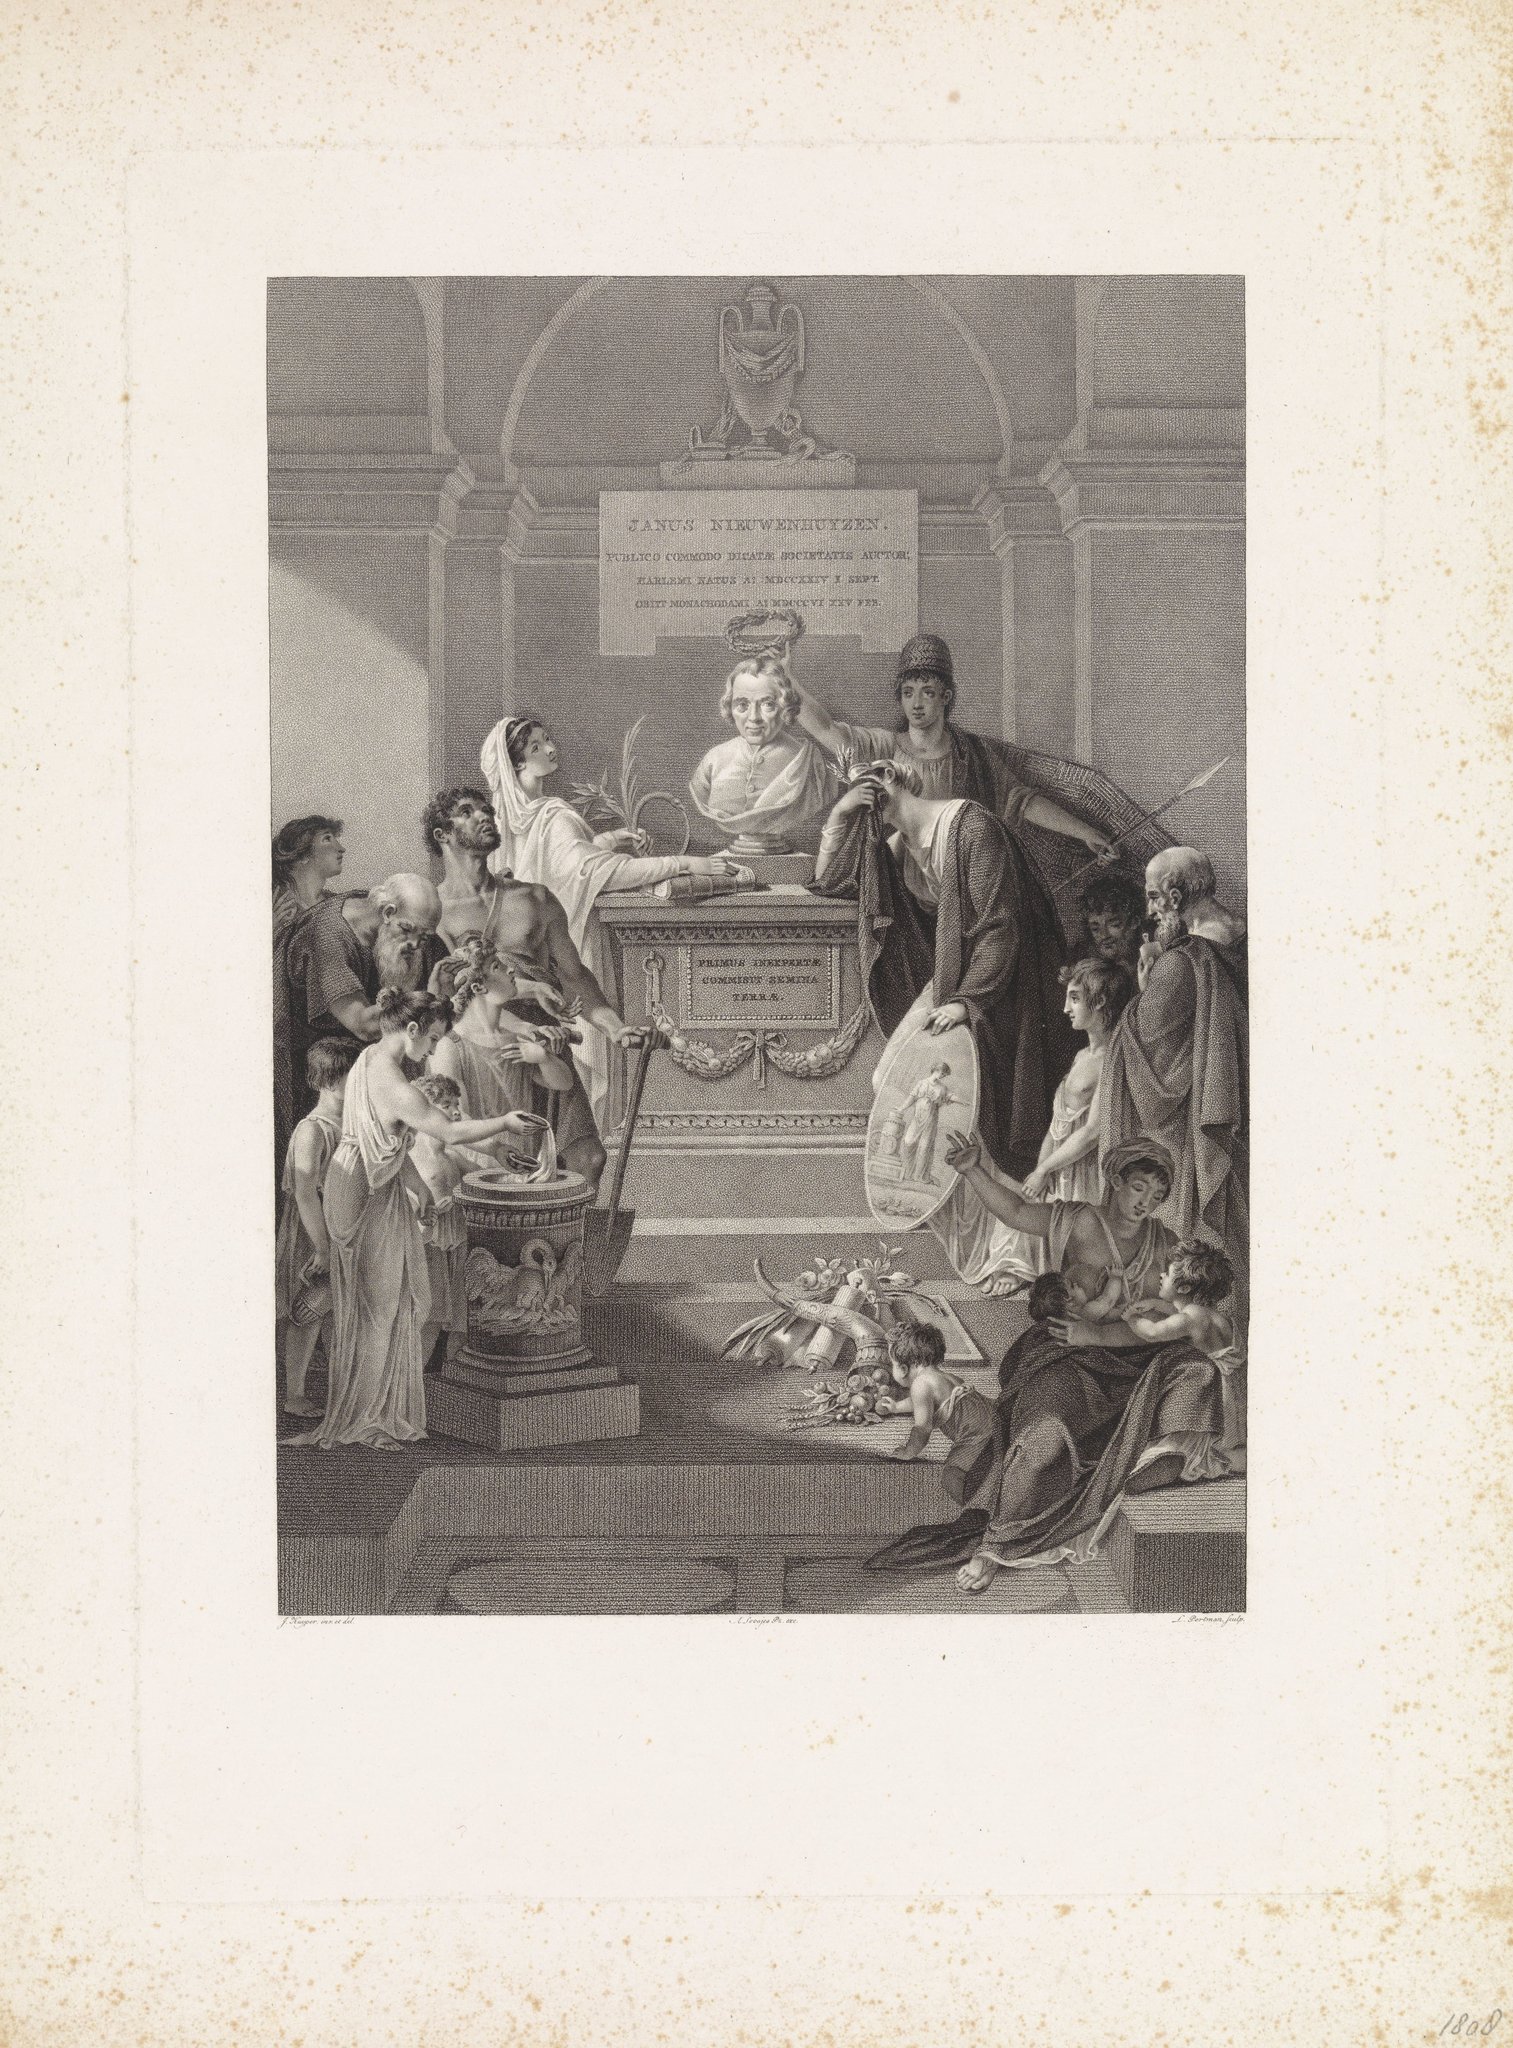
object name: print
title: Allegorische voorstelling met gedenksteen voor Jan Nieuwenhuyzen, overleden in 1806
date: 1806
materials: paper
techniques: etching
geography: haarlem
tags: haarlem, amsterdam, jan nieuwenhuyzen, 'cornucopia', horn of plenty, charity, 'caritas'; 'carità' (ripa) ~ one of the three theological virtues, offering; 'offerta overo oblatione' (ripa) (+ allegorical scene, i.e. two or more personifications involved in an action), symbols, allegories of peace, 'pax'; 'pace' (ripa), serpent ouroboros, urn, crowning with laurel, love towards god; 'amore verso iddio' (ripa), grave, tomb and other grave-forms and grave-markers, youth, adolescence, 'iuventus'; 'adolescenza', 'gioventù' (ripa), the bible as a book, symbols of particular nations, states, districts, etc.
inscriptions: collector's mark: Lugt 2228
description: Gedenksteen voor Jan Nieuwenhuyzen, overleden 25 februari 1806. Op een altaar in een nis staat de buste van Jan Nieuwenhuyzen, stichter van de Maatschappij Tot Nut van 't Algemeen. Daarboven een kader met de naam, geboorte- en sterfdatum van Nieuwenhuyzen. Op het altaar een motto in het Latijn (Hij plantte daar niets stond). De buste wordt gelauwerd door de Hollandse Maagd. Voor haar de personificatie van de Maatschappij die haar betraande gezicht bedekt en leunt op het altaar en haar schild. Aan de andere kant van het altaar kijkt de Godsvrucht op naar de buste. Haar hand rust op een bijbel (Zaligheid), in de andere houdt zij de slang die in zijn eigen staart bijt (Eeuwigheid) en een palmtak (Vrede). Een jonge vrouw, die de Jeugd symboliseert, offert op het altaar van Dankbaarheid. Op de voorgrond zit Liefde, die wijst op de buste van de stichter. Een van de kinderen reikt naar de vruchten uit de hoorn des overvloeds (het kind plukt reeds de vruchten van de stichting van de Maatschappij).